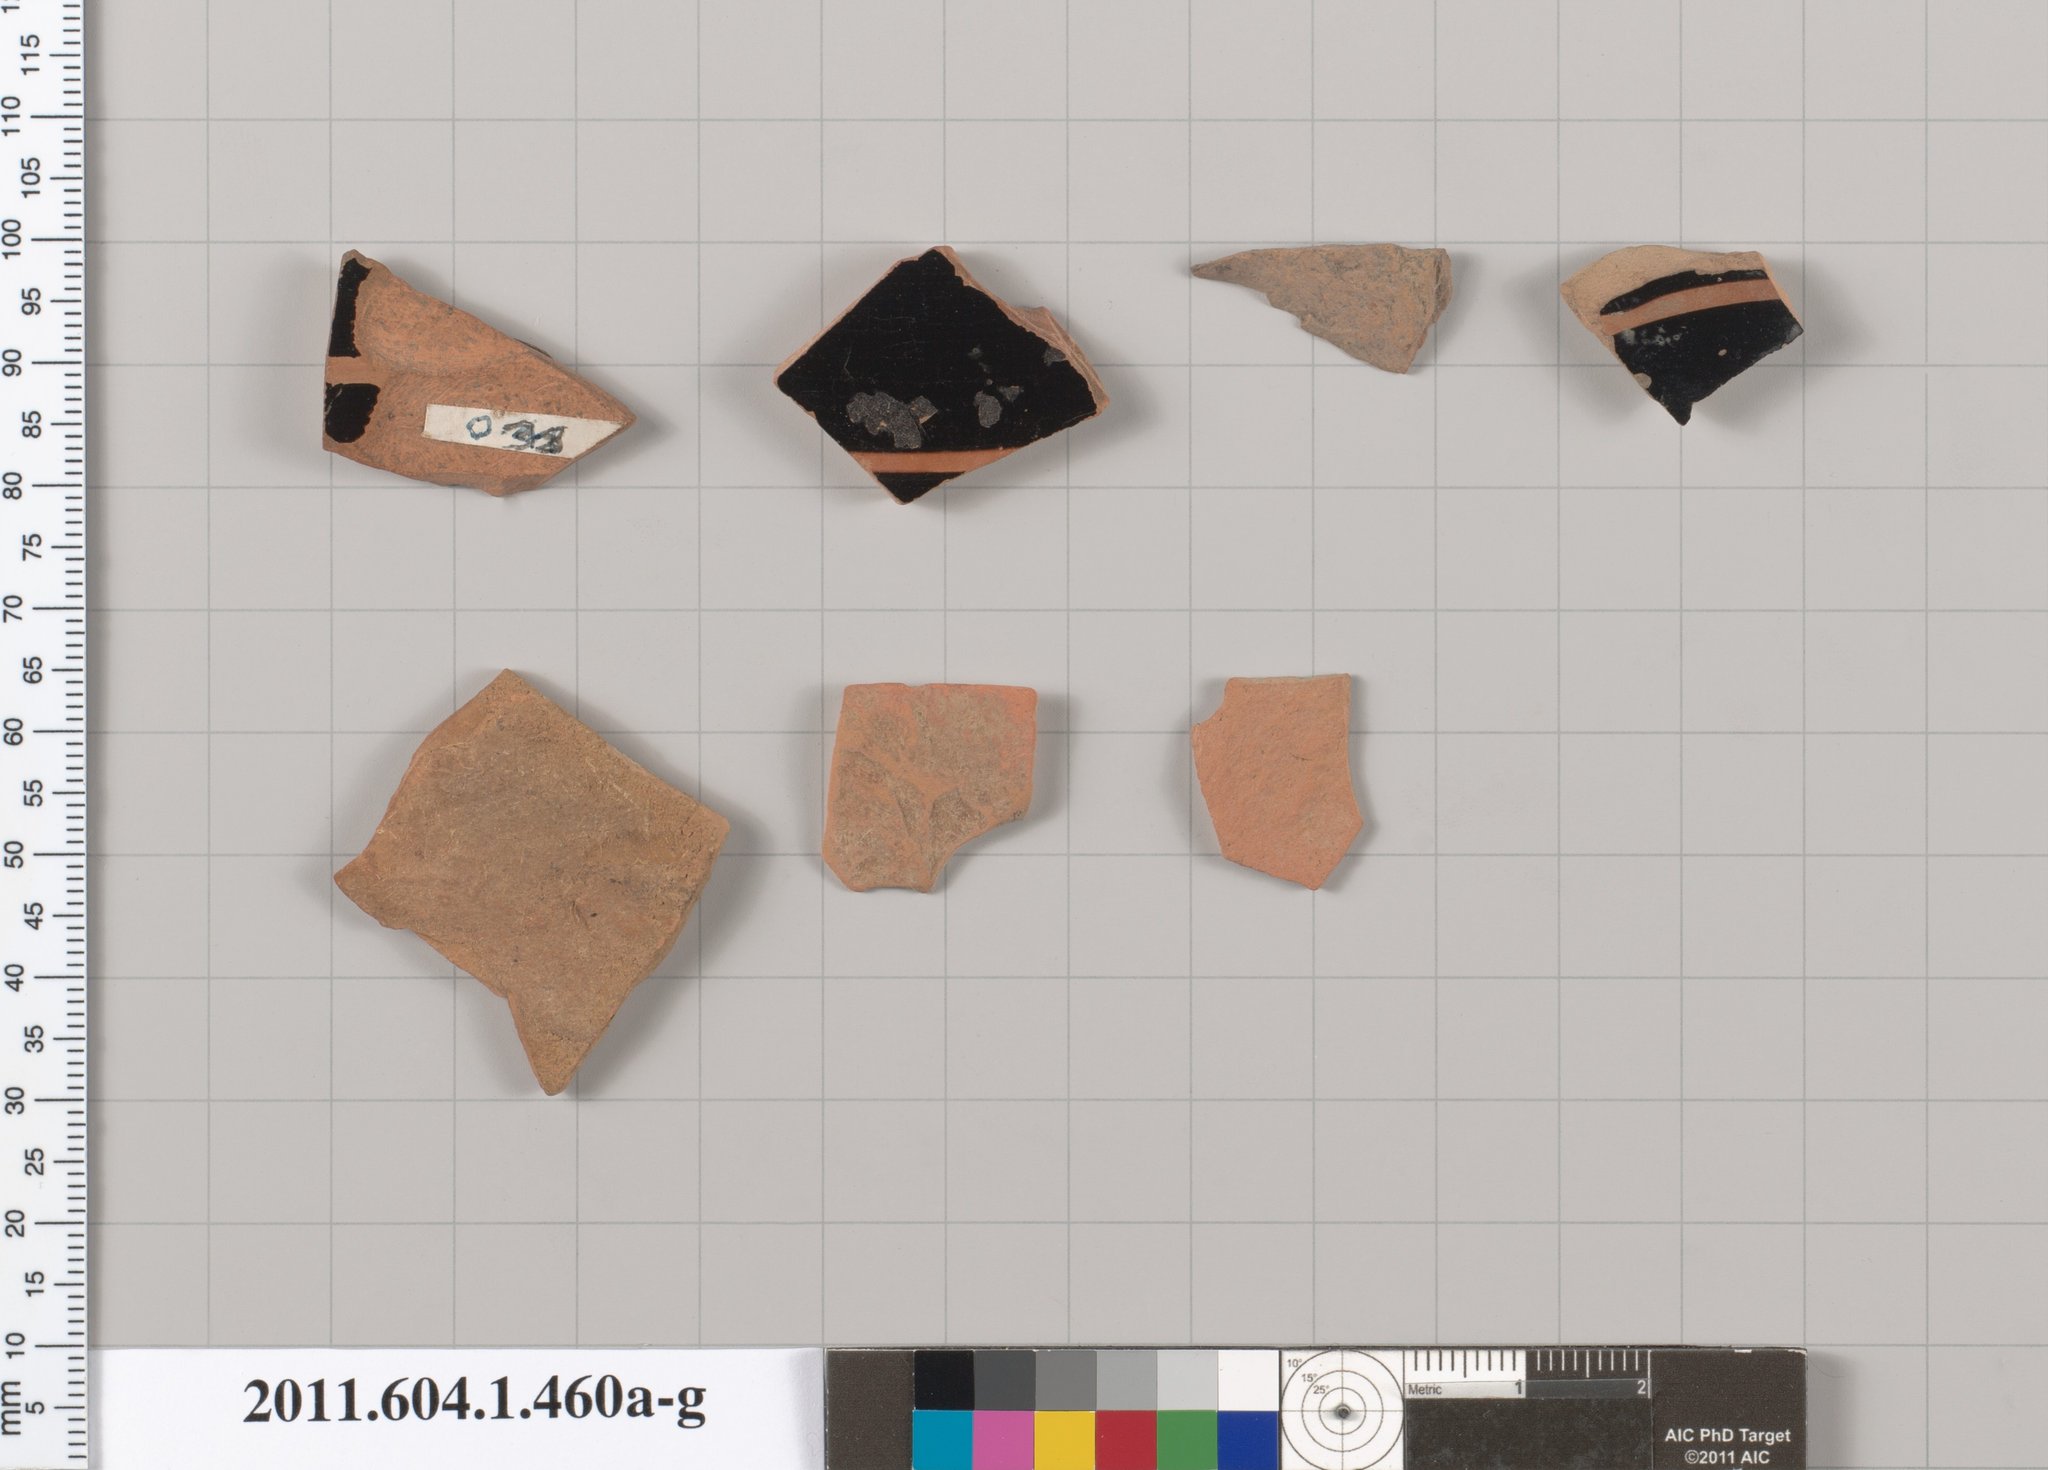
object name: kylix fragment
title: Terracotta fragments of kylikes (drinking cups)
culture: greek, attic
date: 401-500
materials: terracotta